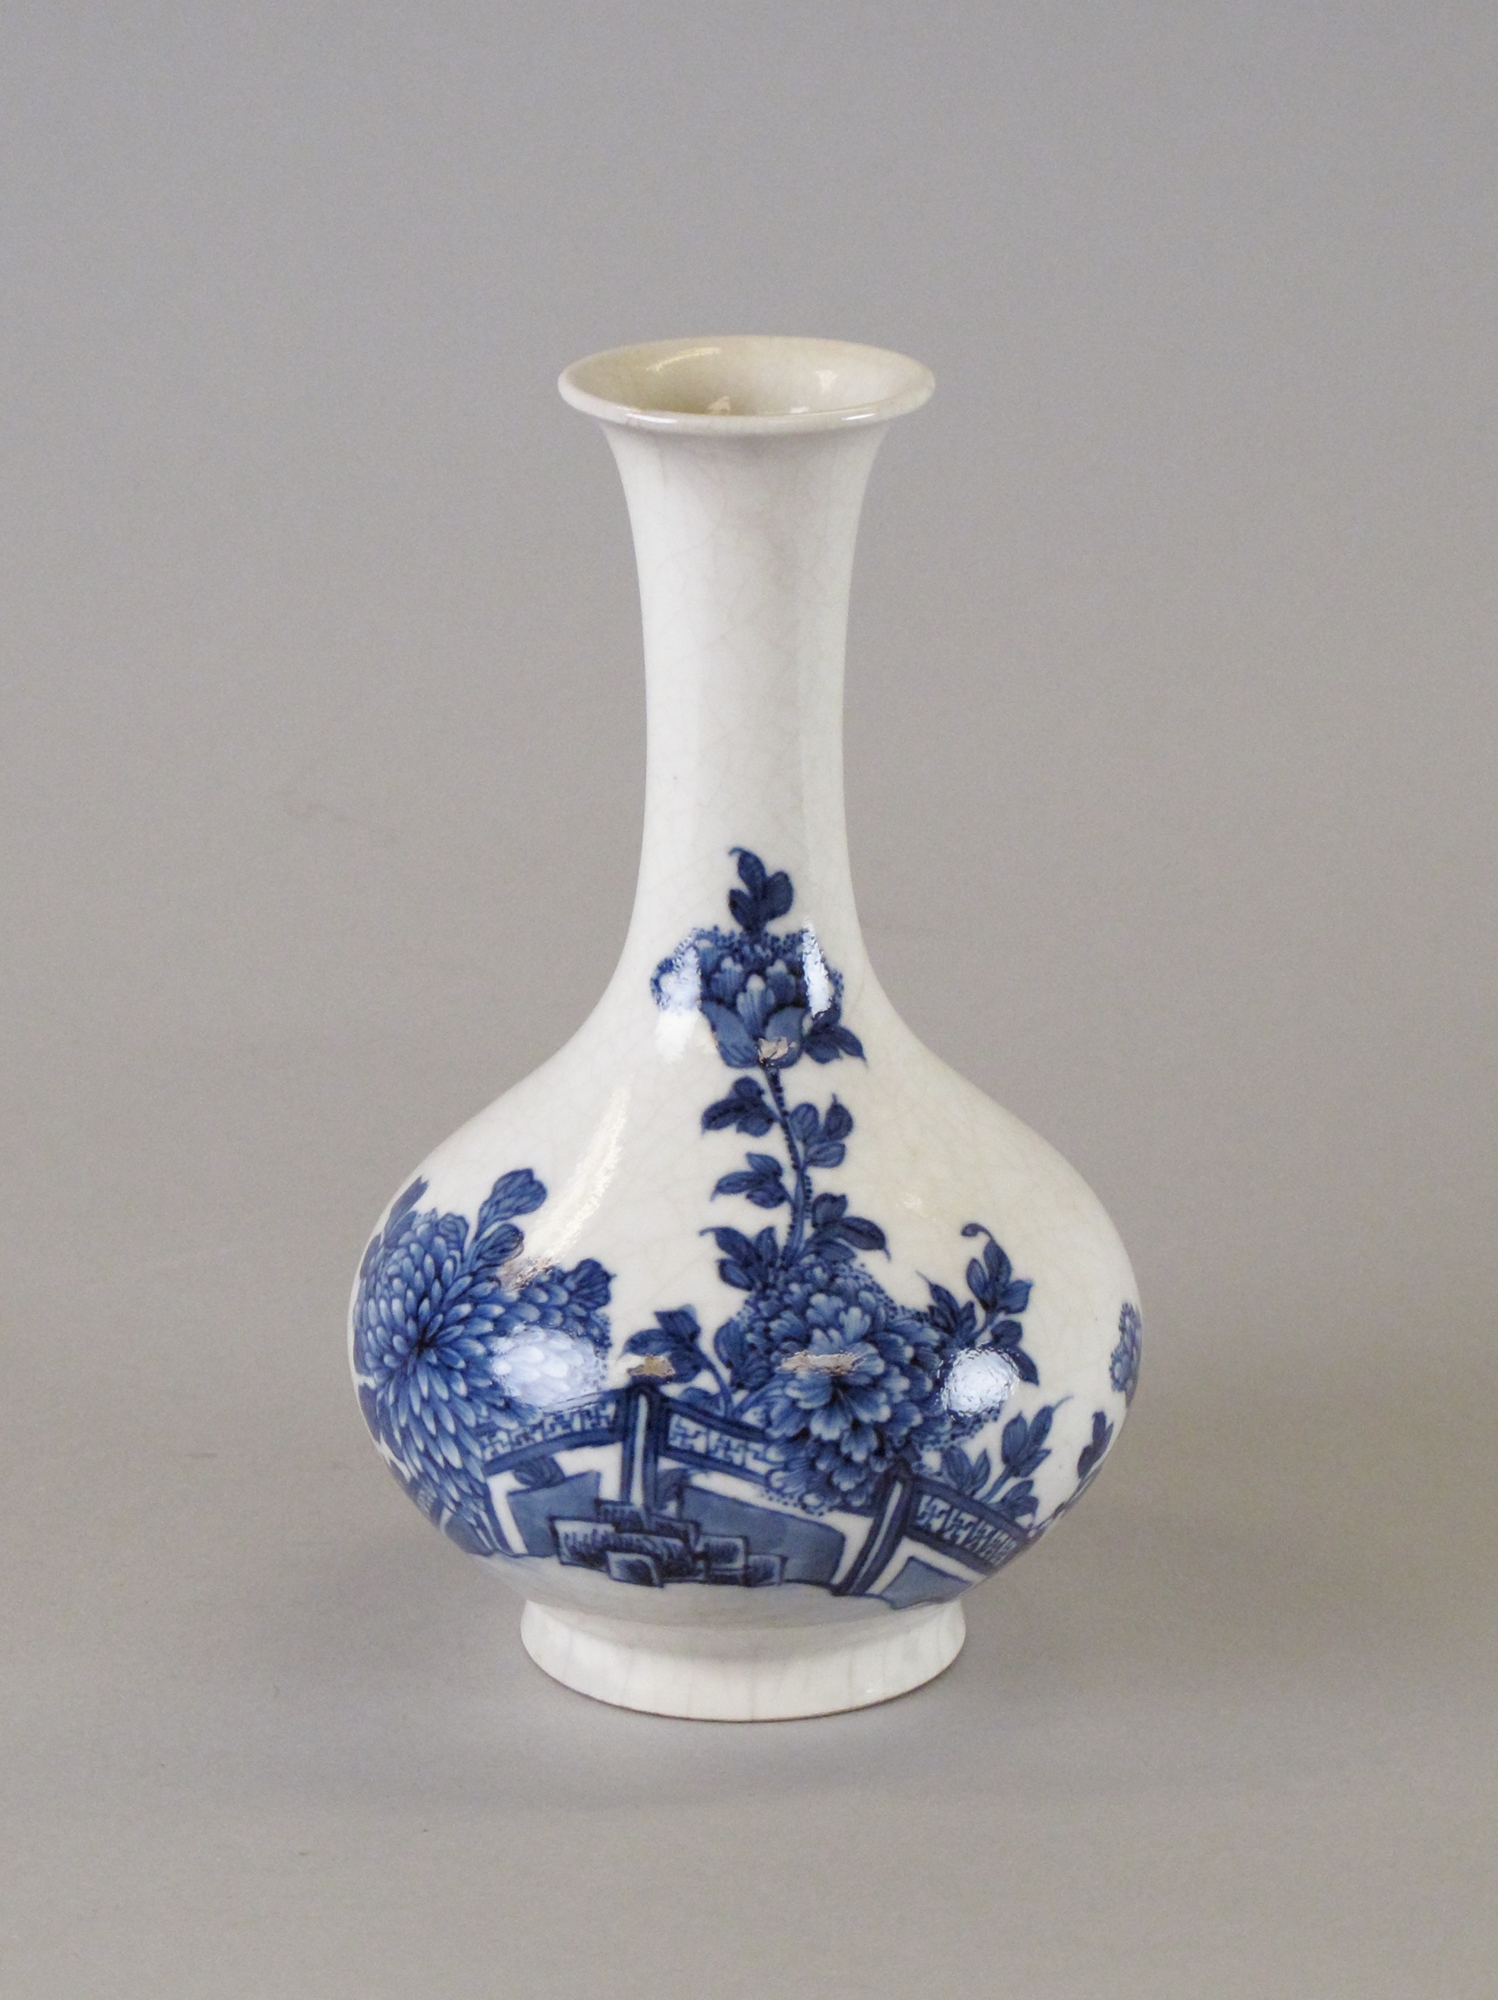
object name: bottle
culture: chinese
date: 1736-1795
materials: glaze, porcelain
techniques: underglaze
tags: flowers